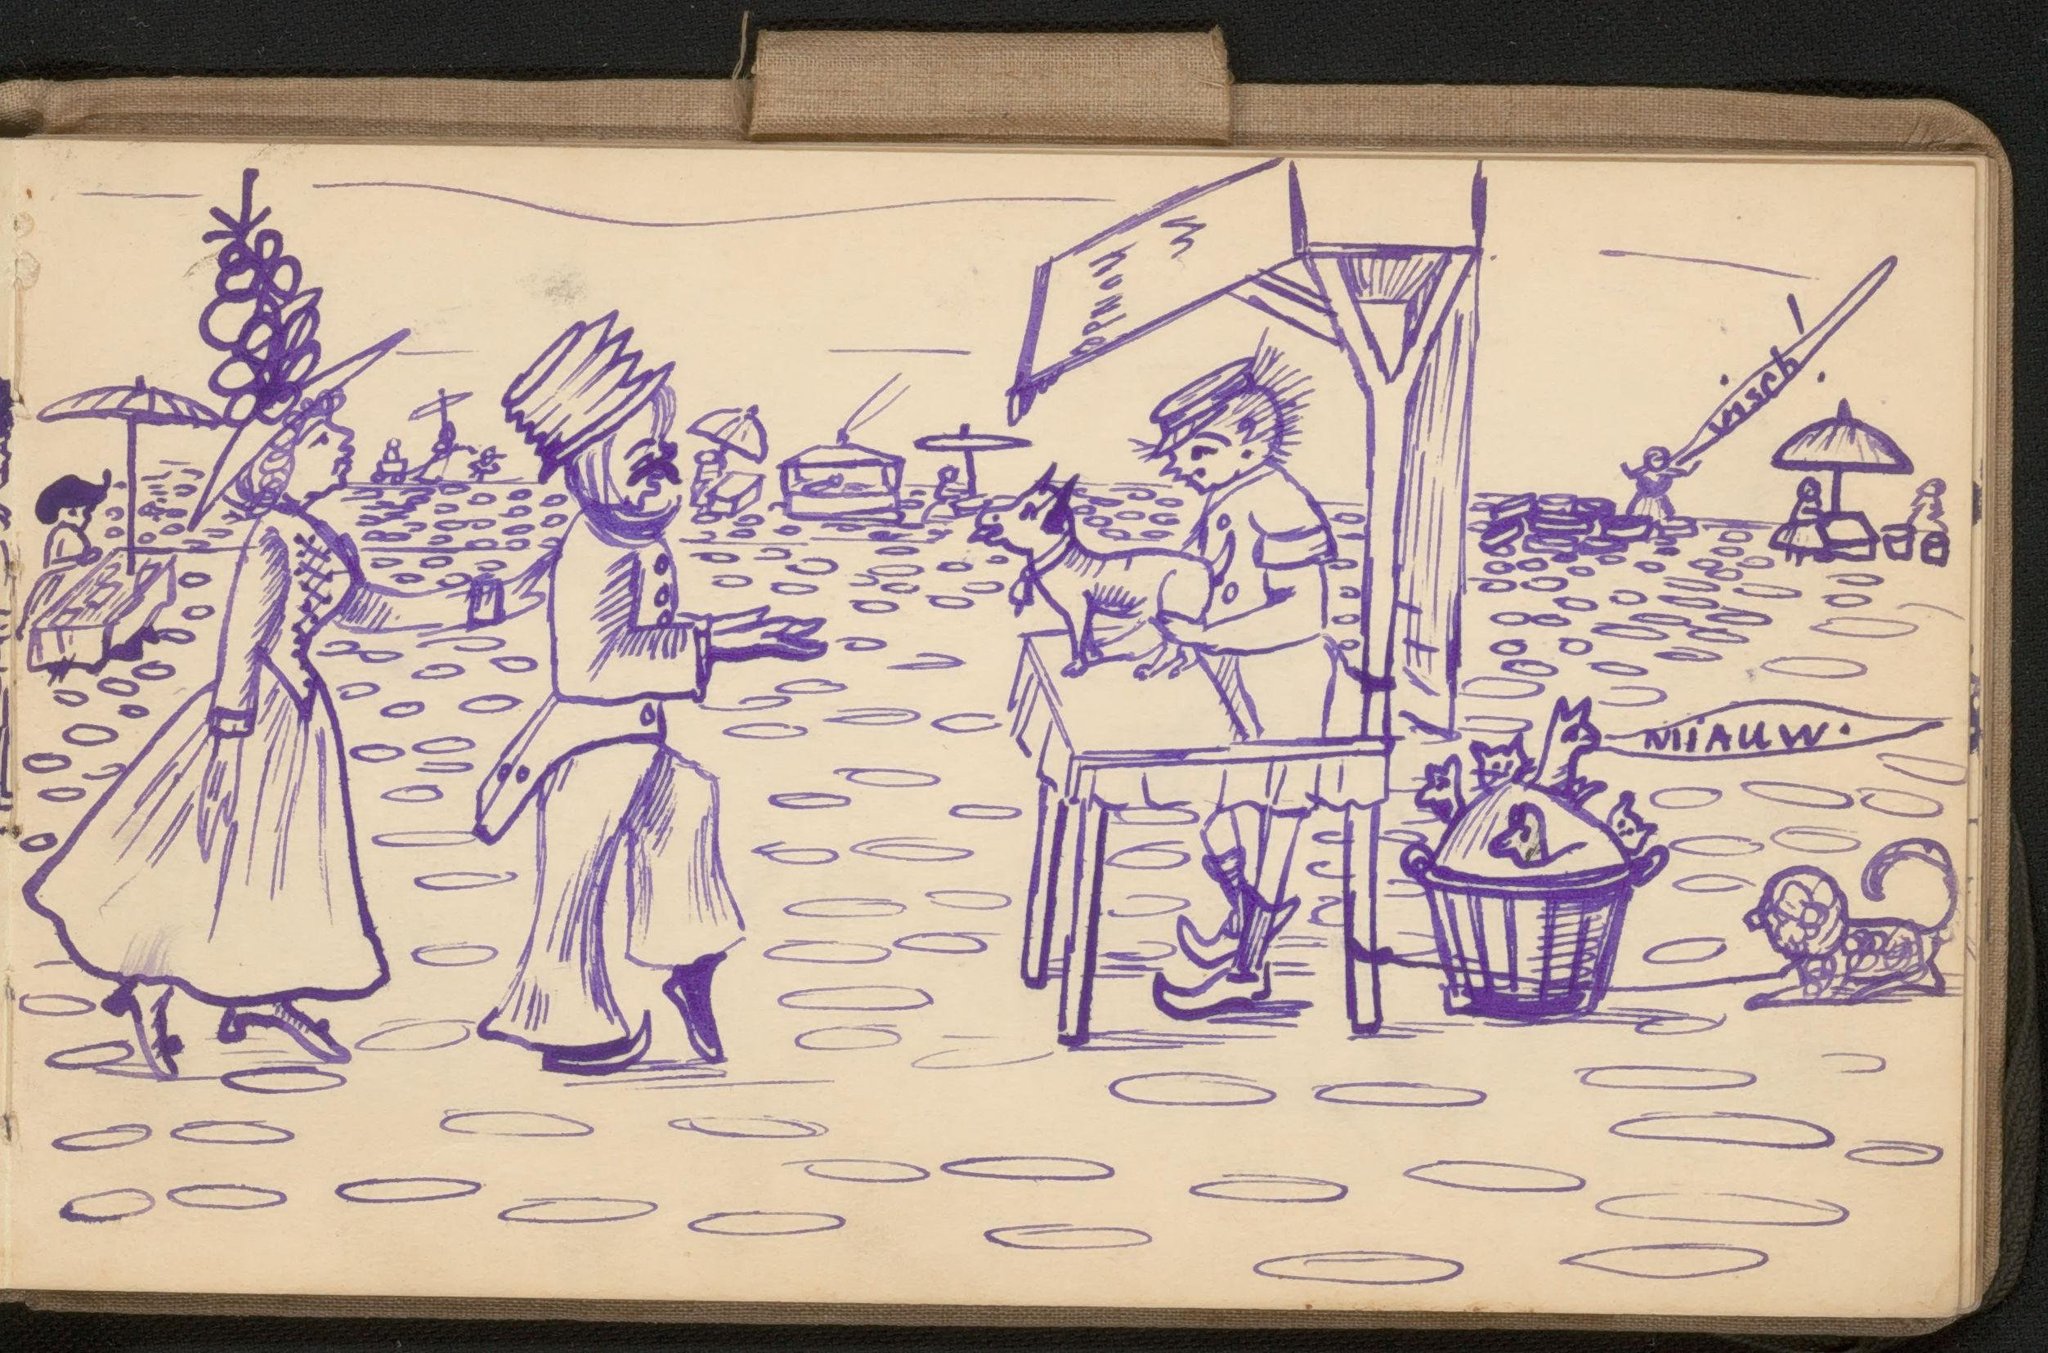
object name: sketchbook leaf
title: Pa koopt een hond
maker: Anonymous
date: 1875-1920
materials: ink, paper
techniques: pen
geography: netherlands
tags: stall, booth (~ market), street-trader, dog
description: Pa koopt een hond bij een markstal. Onderdeel van het schetsboek met humoristische tekeningen over het leven van een 'famille nombreuse'. Onderwerpsrubrieken binnen de Atlas Zeden en Gewoonten: Zeden en Gewoonten in Engeren Zin, Des menschen beging, midden en einde, Kinderleven.